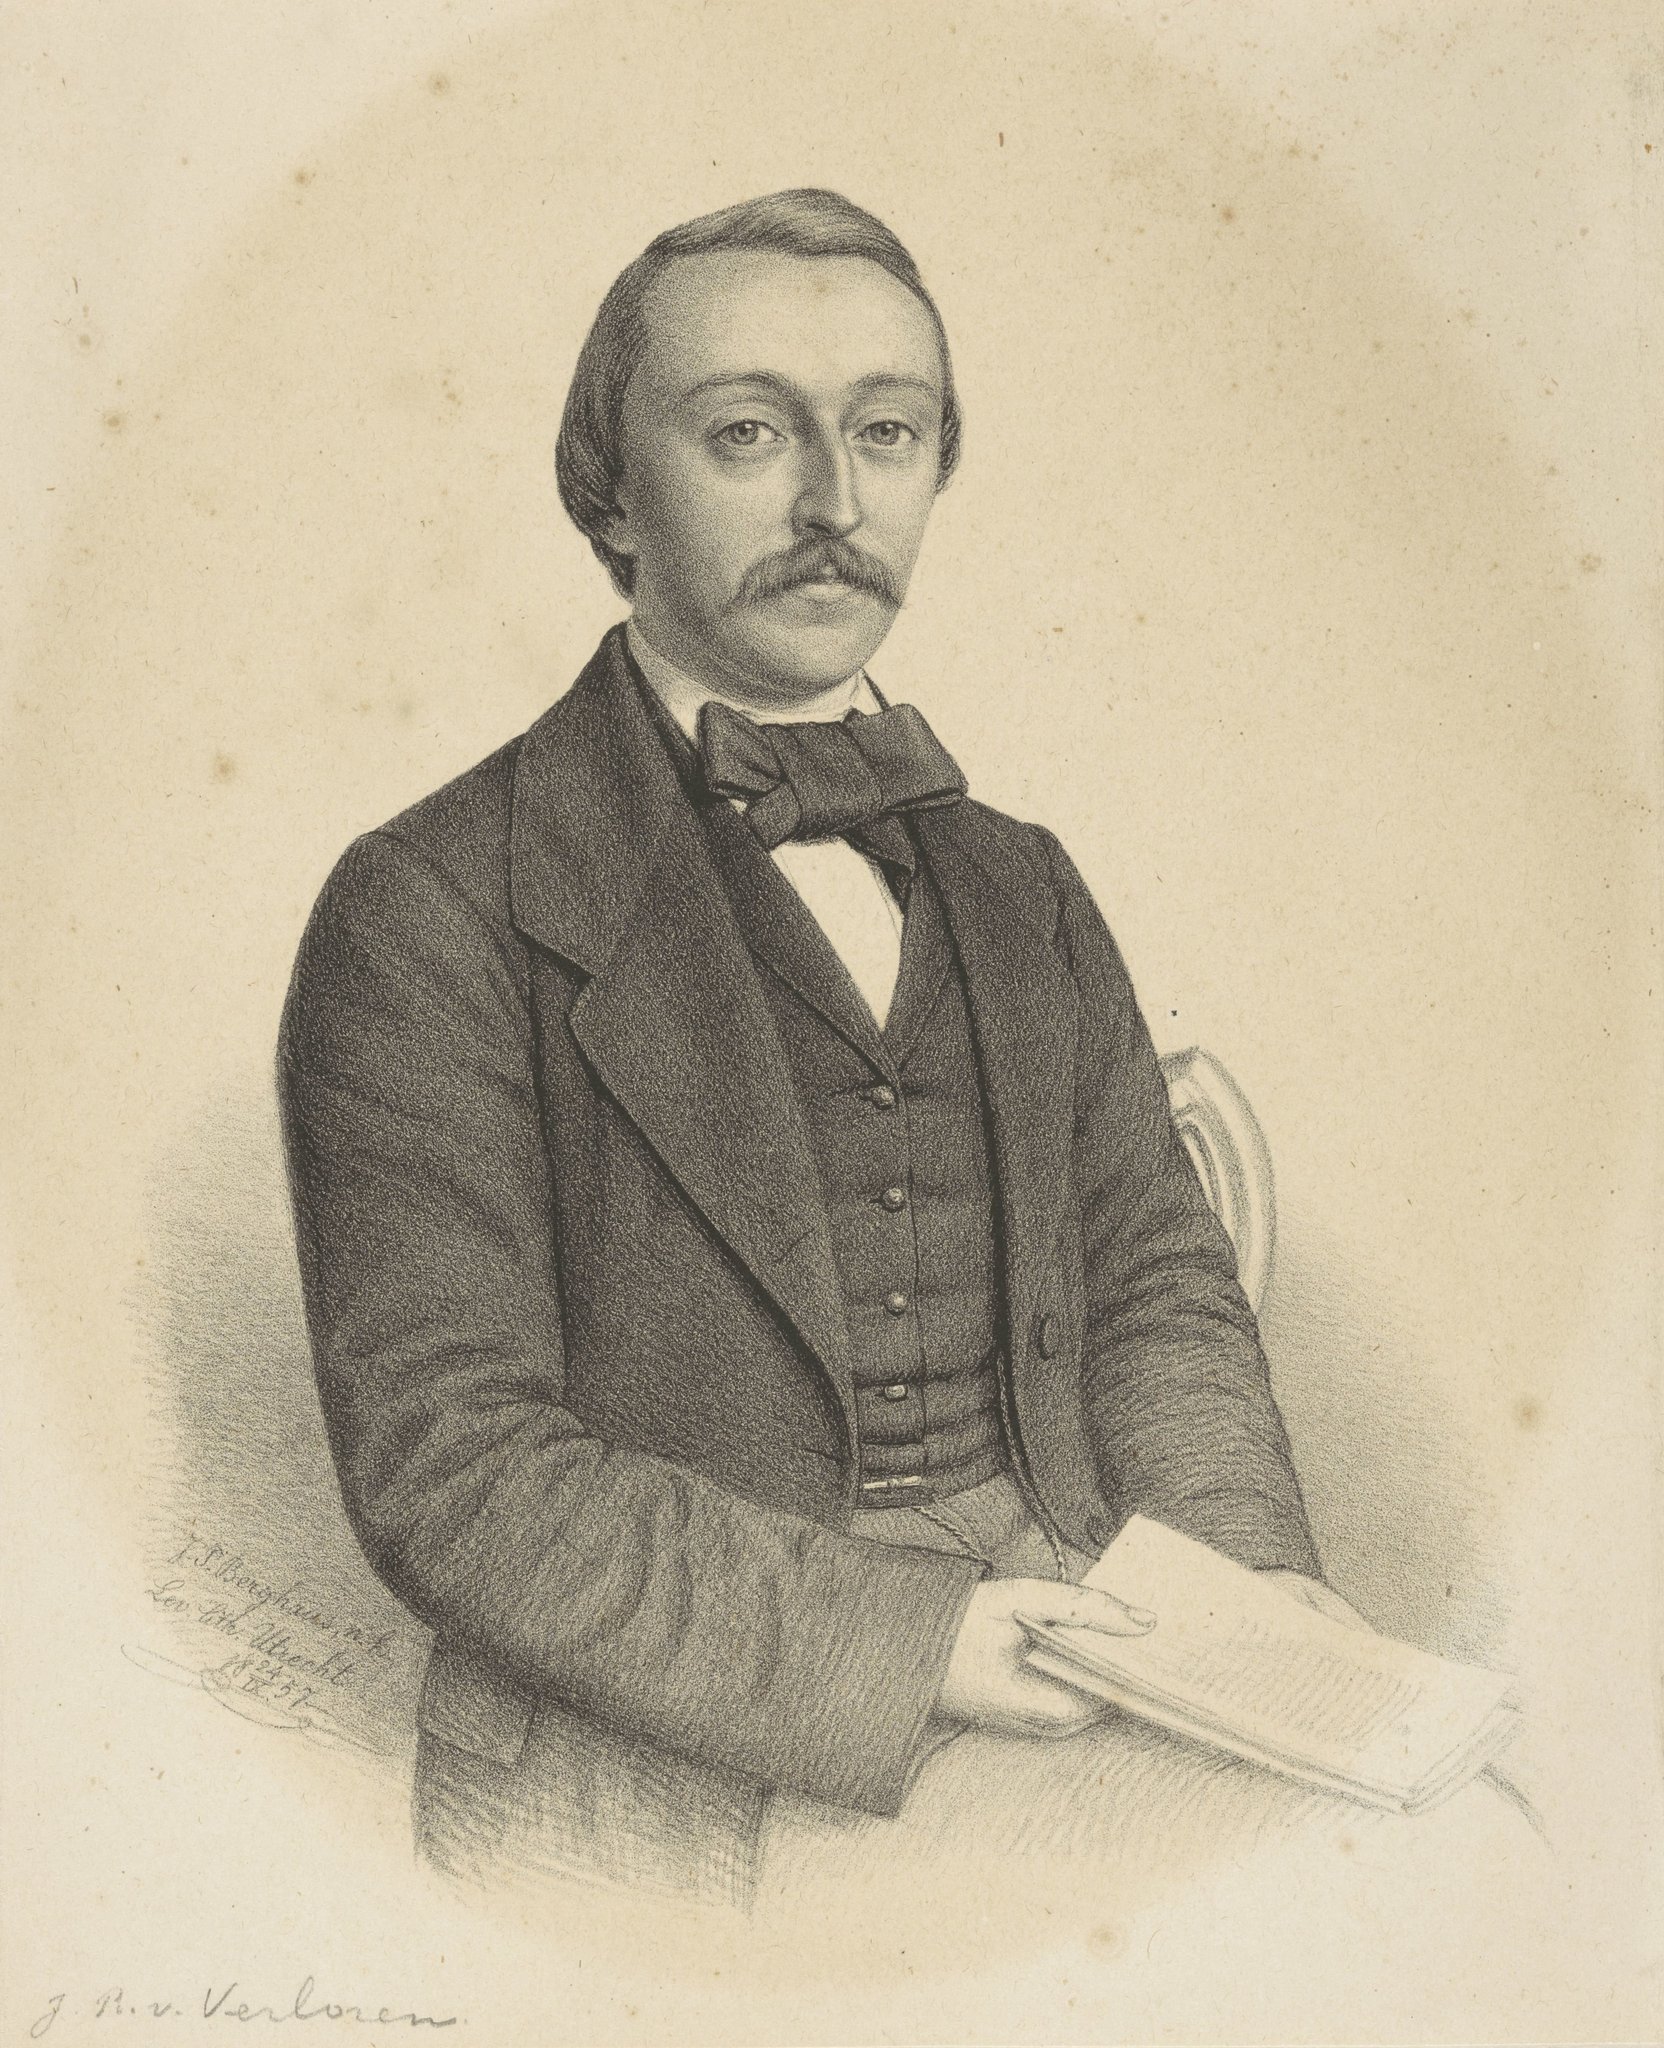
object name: print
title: Portret van een onbekende man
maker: johann peter berghaus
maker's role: print maker, printer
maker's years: 1810-1870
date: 1857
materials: paper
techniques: lithograph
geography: utrecht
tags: historical persons, paper (writing material)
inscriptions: inscription: ‘J.R. van Verloren / Leg vd Velden’, collector's mark: Lugt 2228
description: De geportretteerde zit op een stoel. Hij heeft enkele papieren met tekstregels in zijn handen.